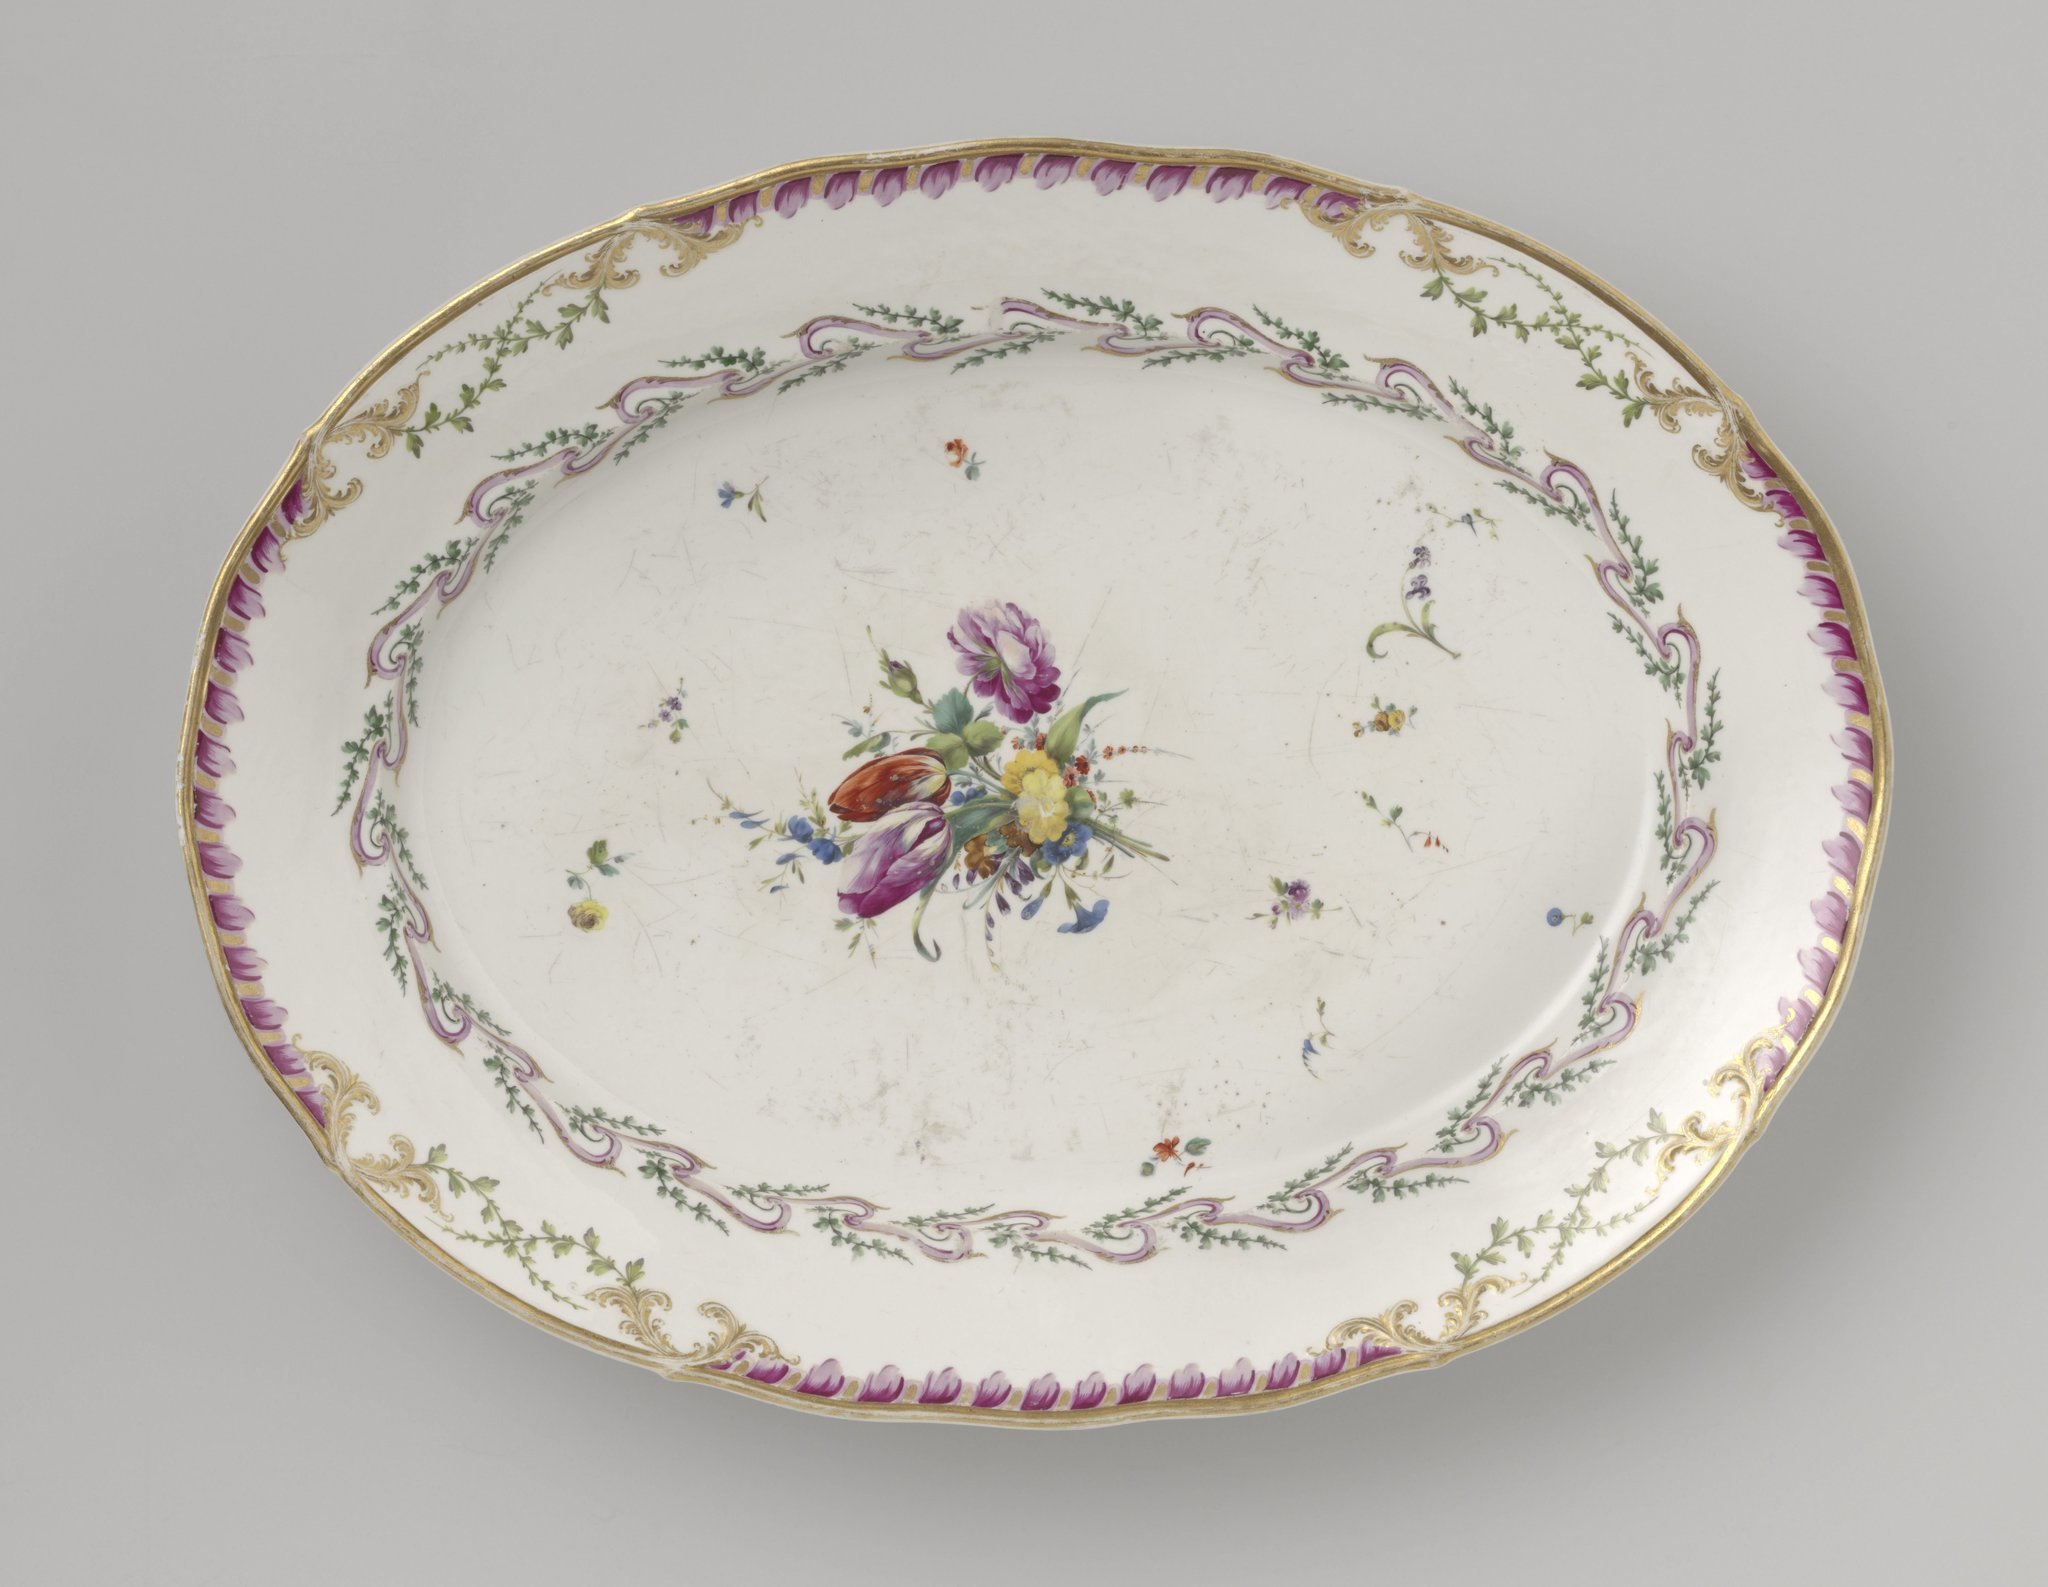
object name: platter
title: Schotel, plat, groot en ovaal, behorend bij een servies met geslingerd lintmotief met bladertakken, bloemboeketten en gestrooide bloemtakken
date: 1780-1820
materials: porcelain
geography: amsterdam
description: Schotel, plat, groot en ovaal, behorend bij een servies van porselein, versierd met een geslingerd lintmotief in paars en goud met groene bladertakken, bloemboeketten en gestrooide bloemtakken. Randen lichtgegolfd met decoratie in goud met paars bladmotief waartussen groen gekruist bladmotief. Gemerkt: M.O.L. en Amstel.